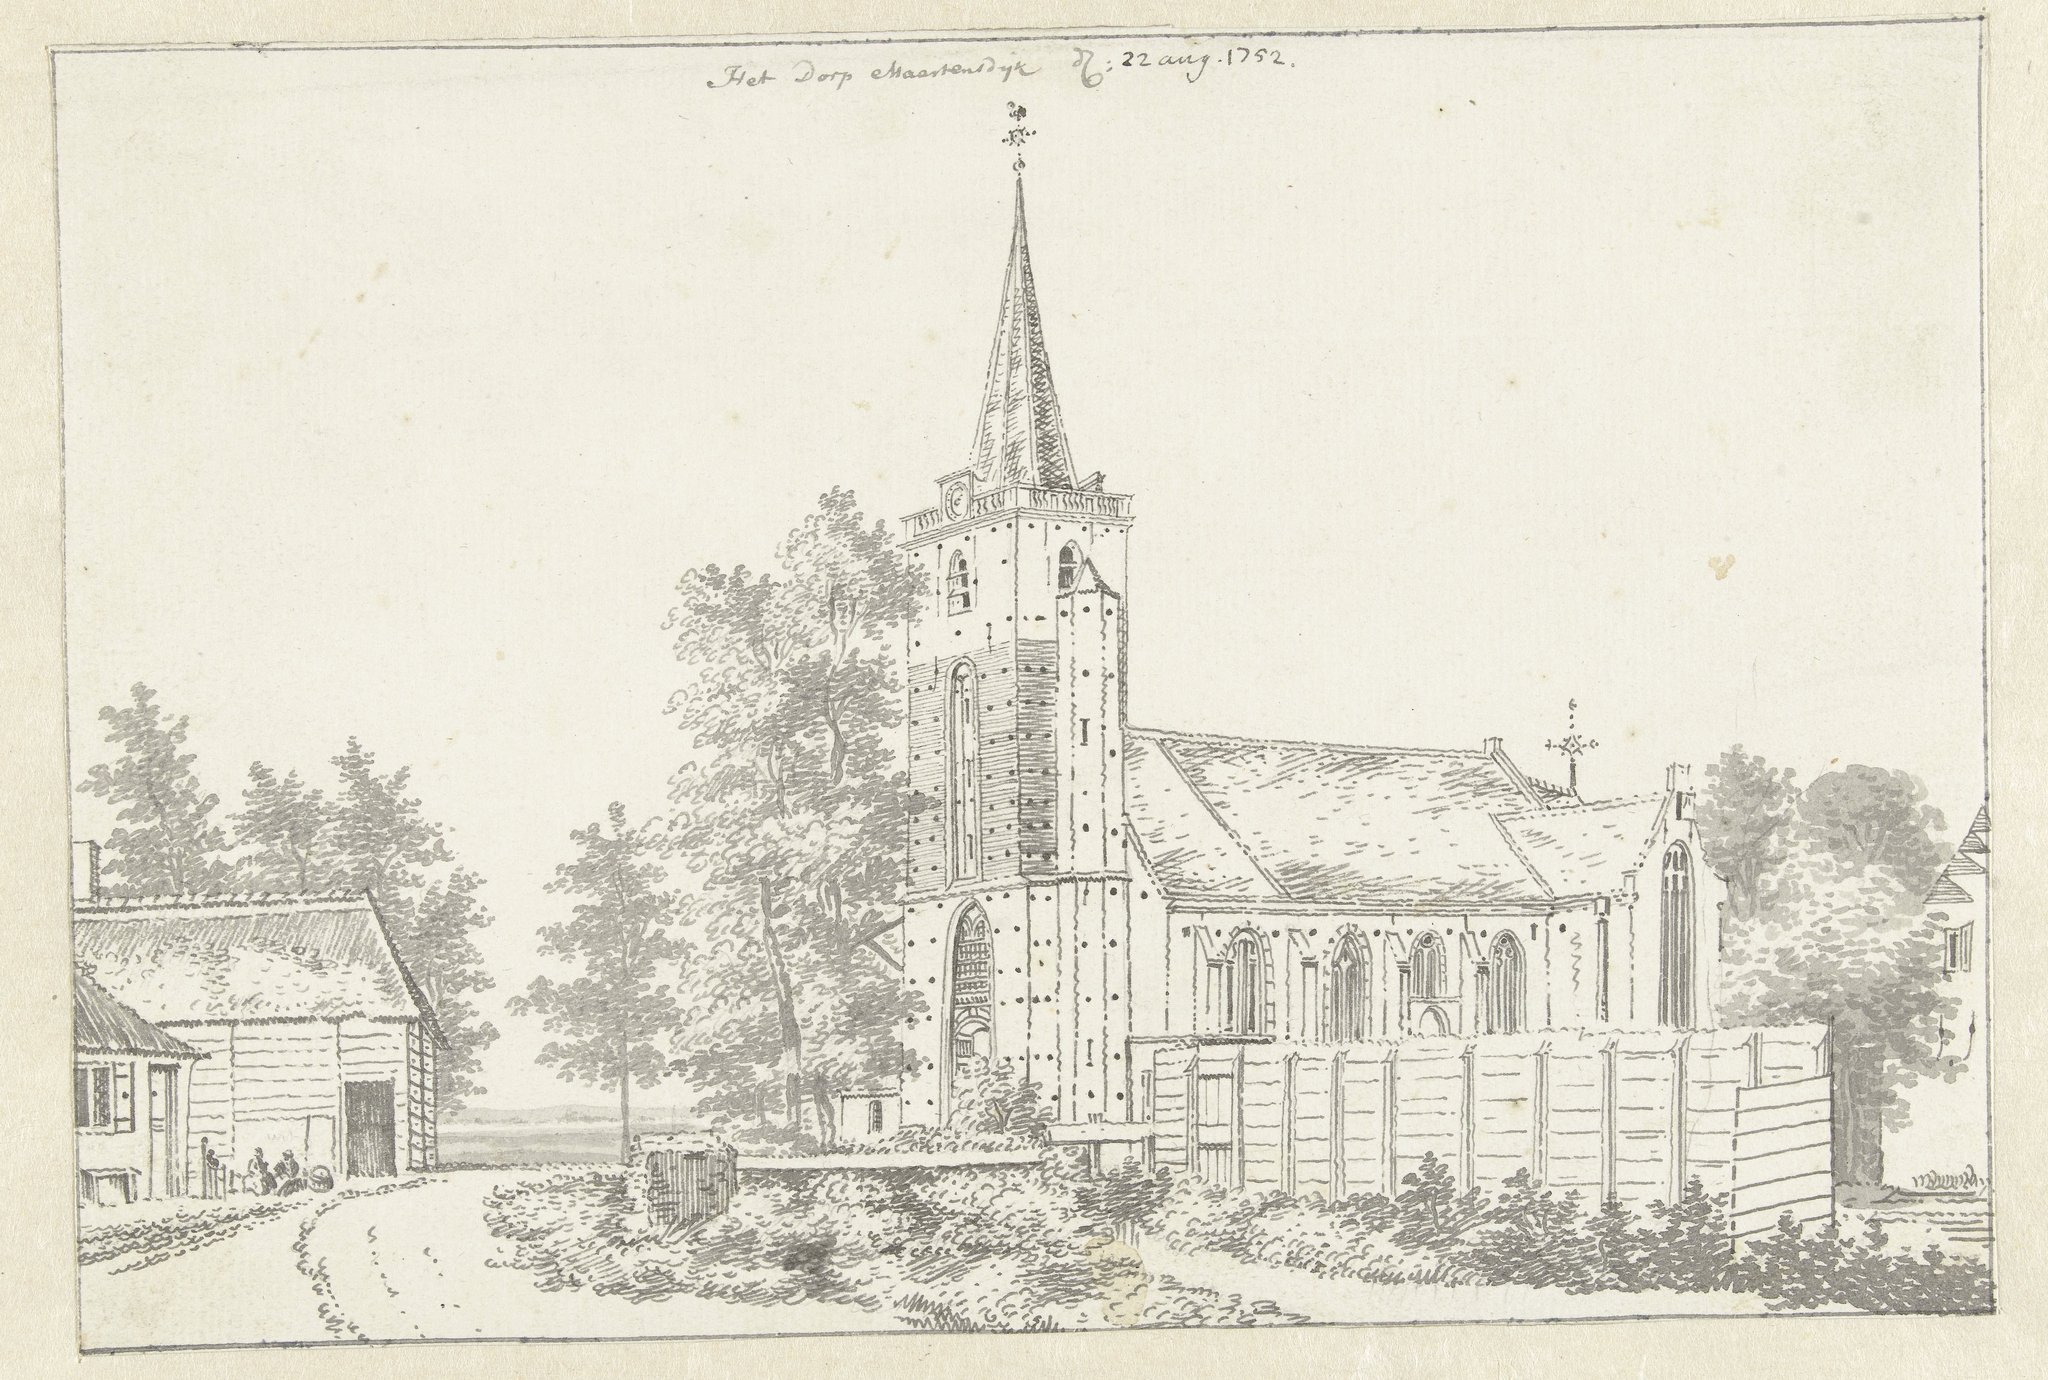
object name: drawing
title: De kerk van Maartensdijk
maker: jan de beijer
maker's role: draughtsman, print maker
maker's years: 1703-1780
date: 1752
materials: ink, paper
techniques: brush, pen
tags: church (exterior), public road